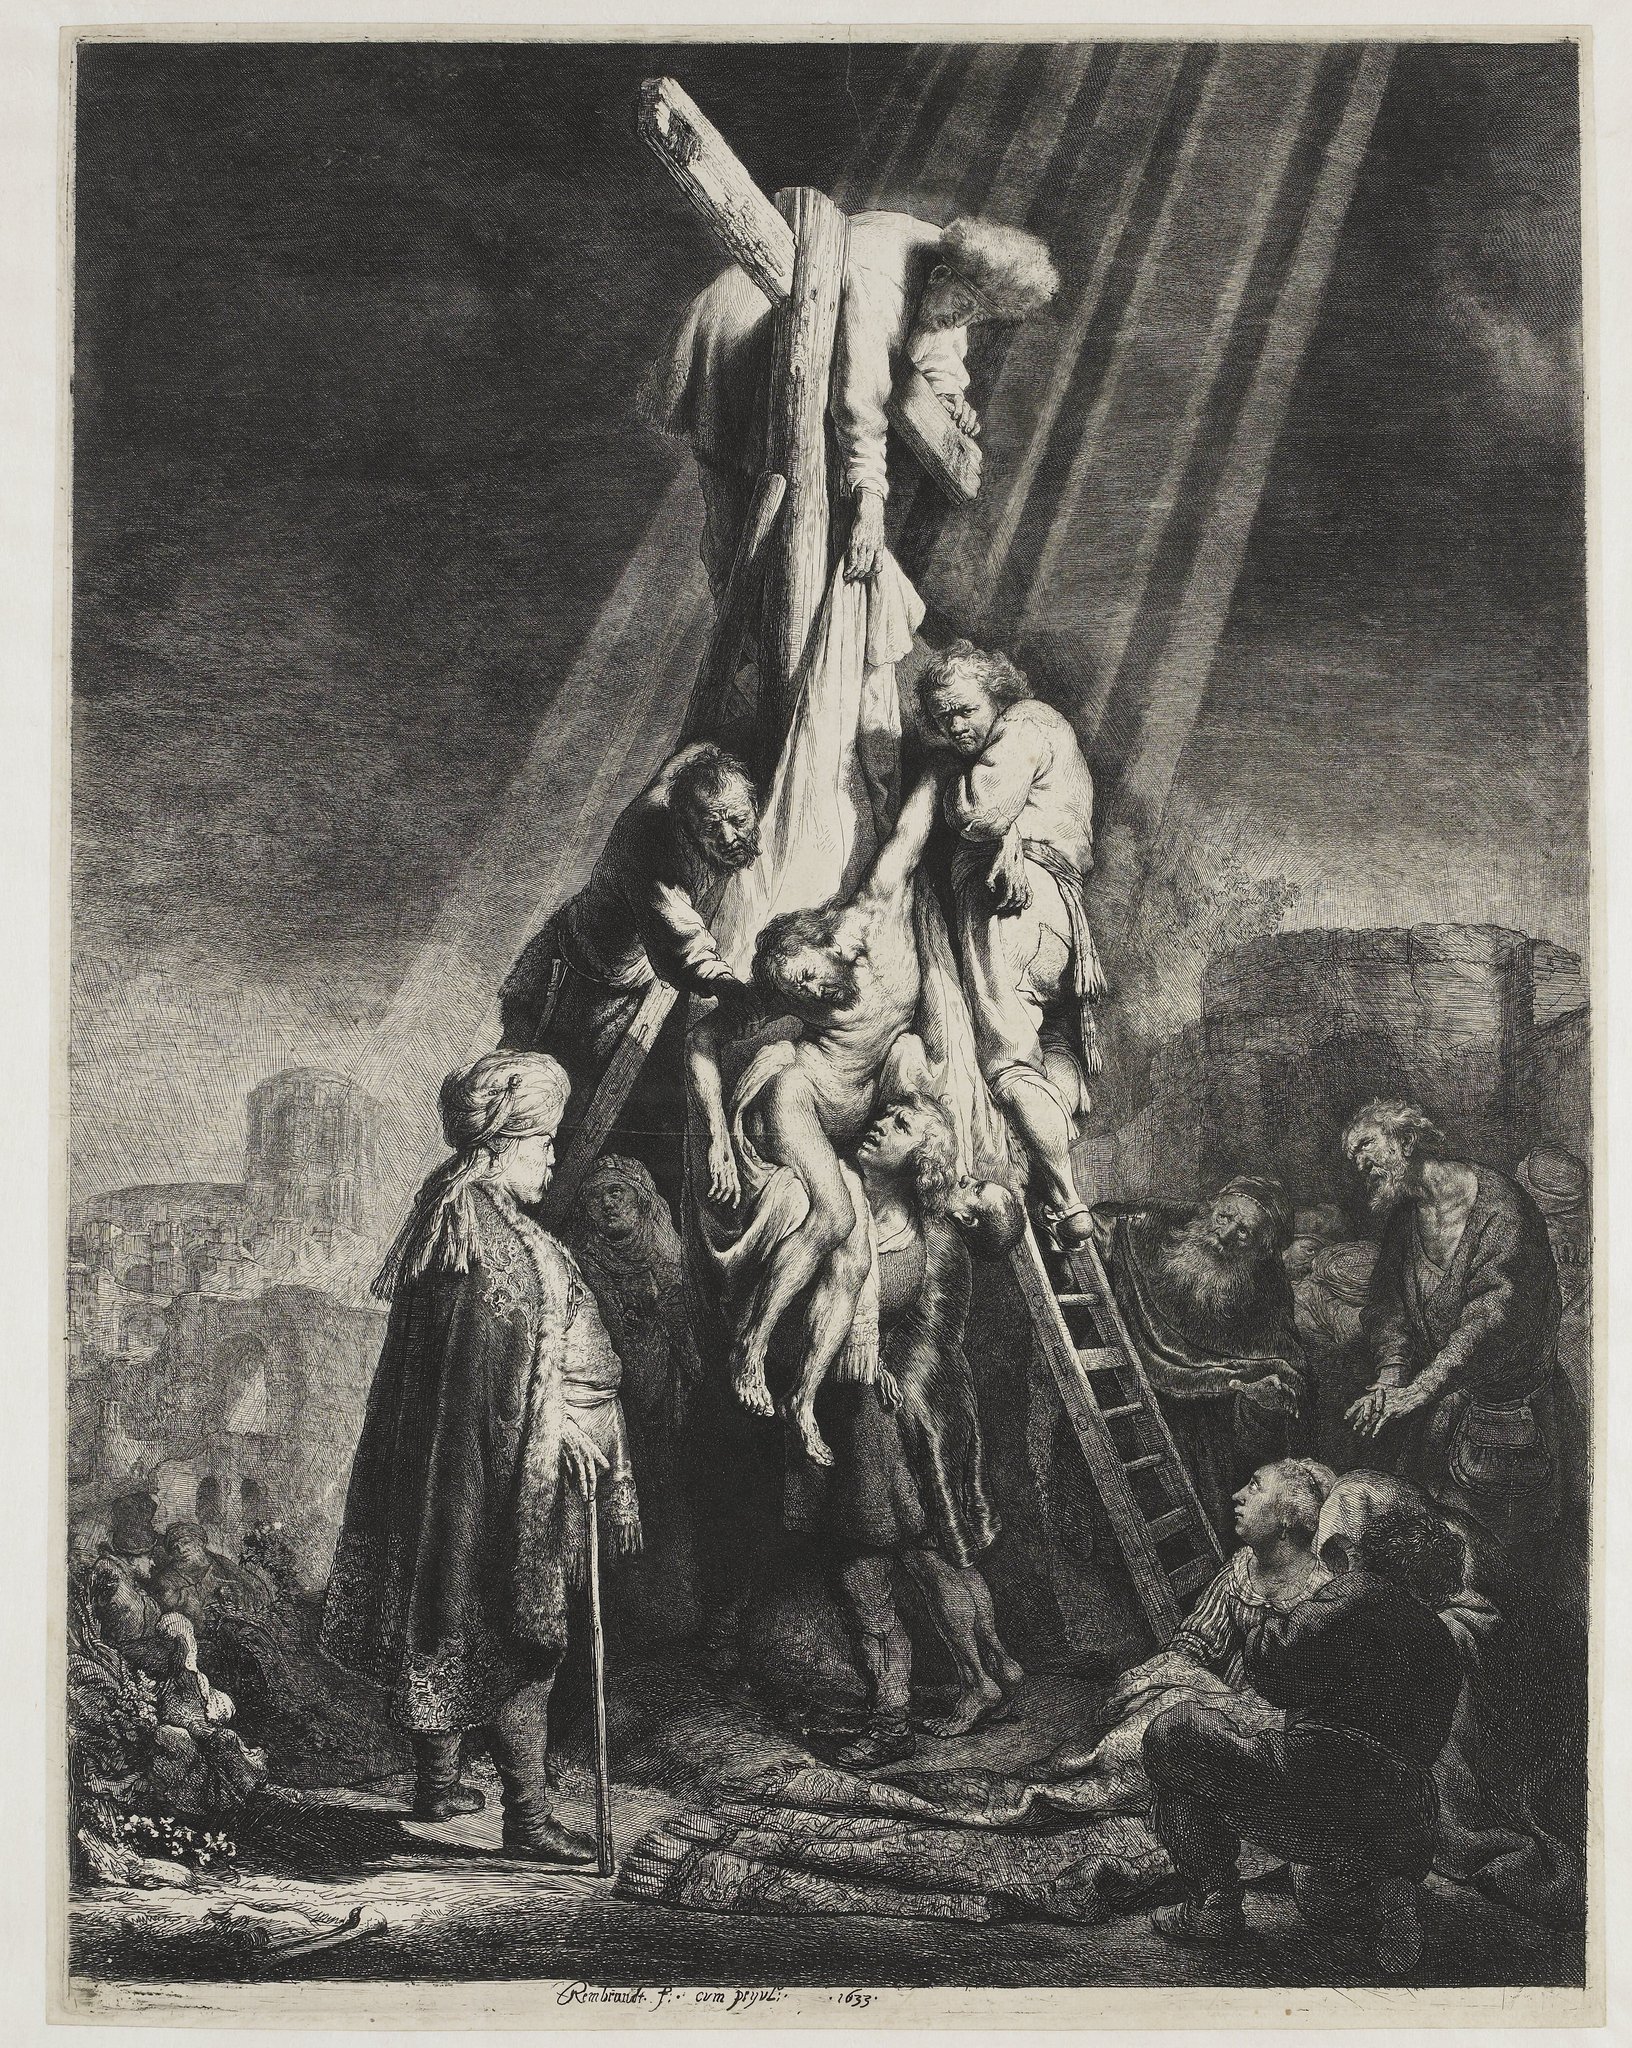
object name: print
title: The descent from the cross: second plate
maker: rembrandt van rijn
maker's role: draughtsman, painter, print maker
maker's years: 1606-1669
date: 1633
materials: paper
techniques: etching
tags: descent from the cross: christ is taken down from the cross, usually by nicodemus and joseph of arimathaea who are standing on the ladders (both arms of christ detached)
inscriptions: collector's mark: Lugt 240, signature and date: ‘Rembrandt. f. cvm pryvl.o .1633.’